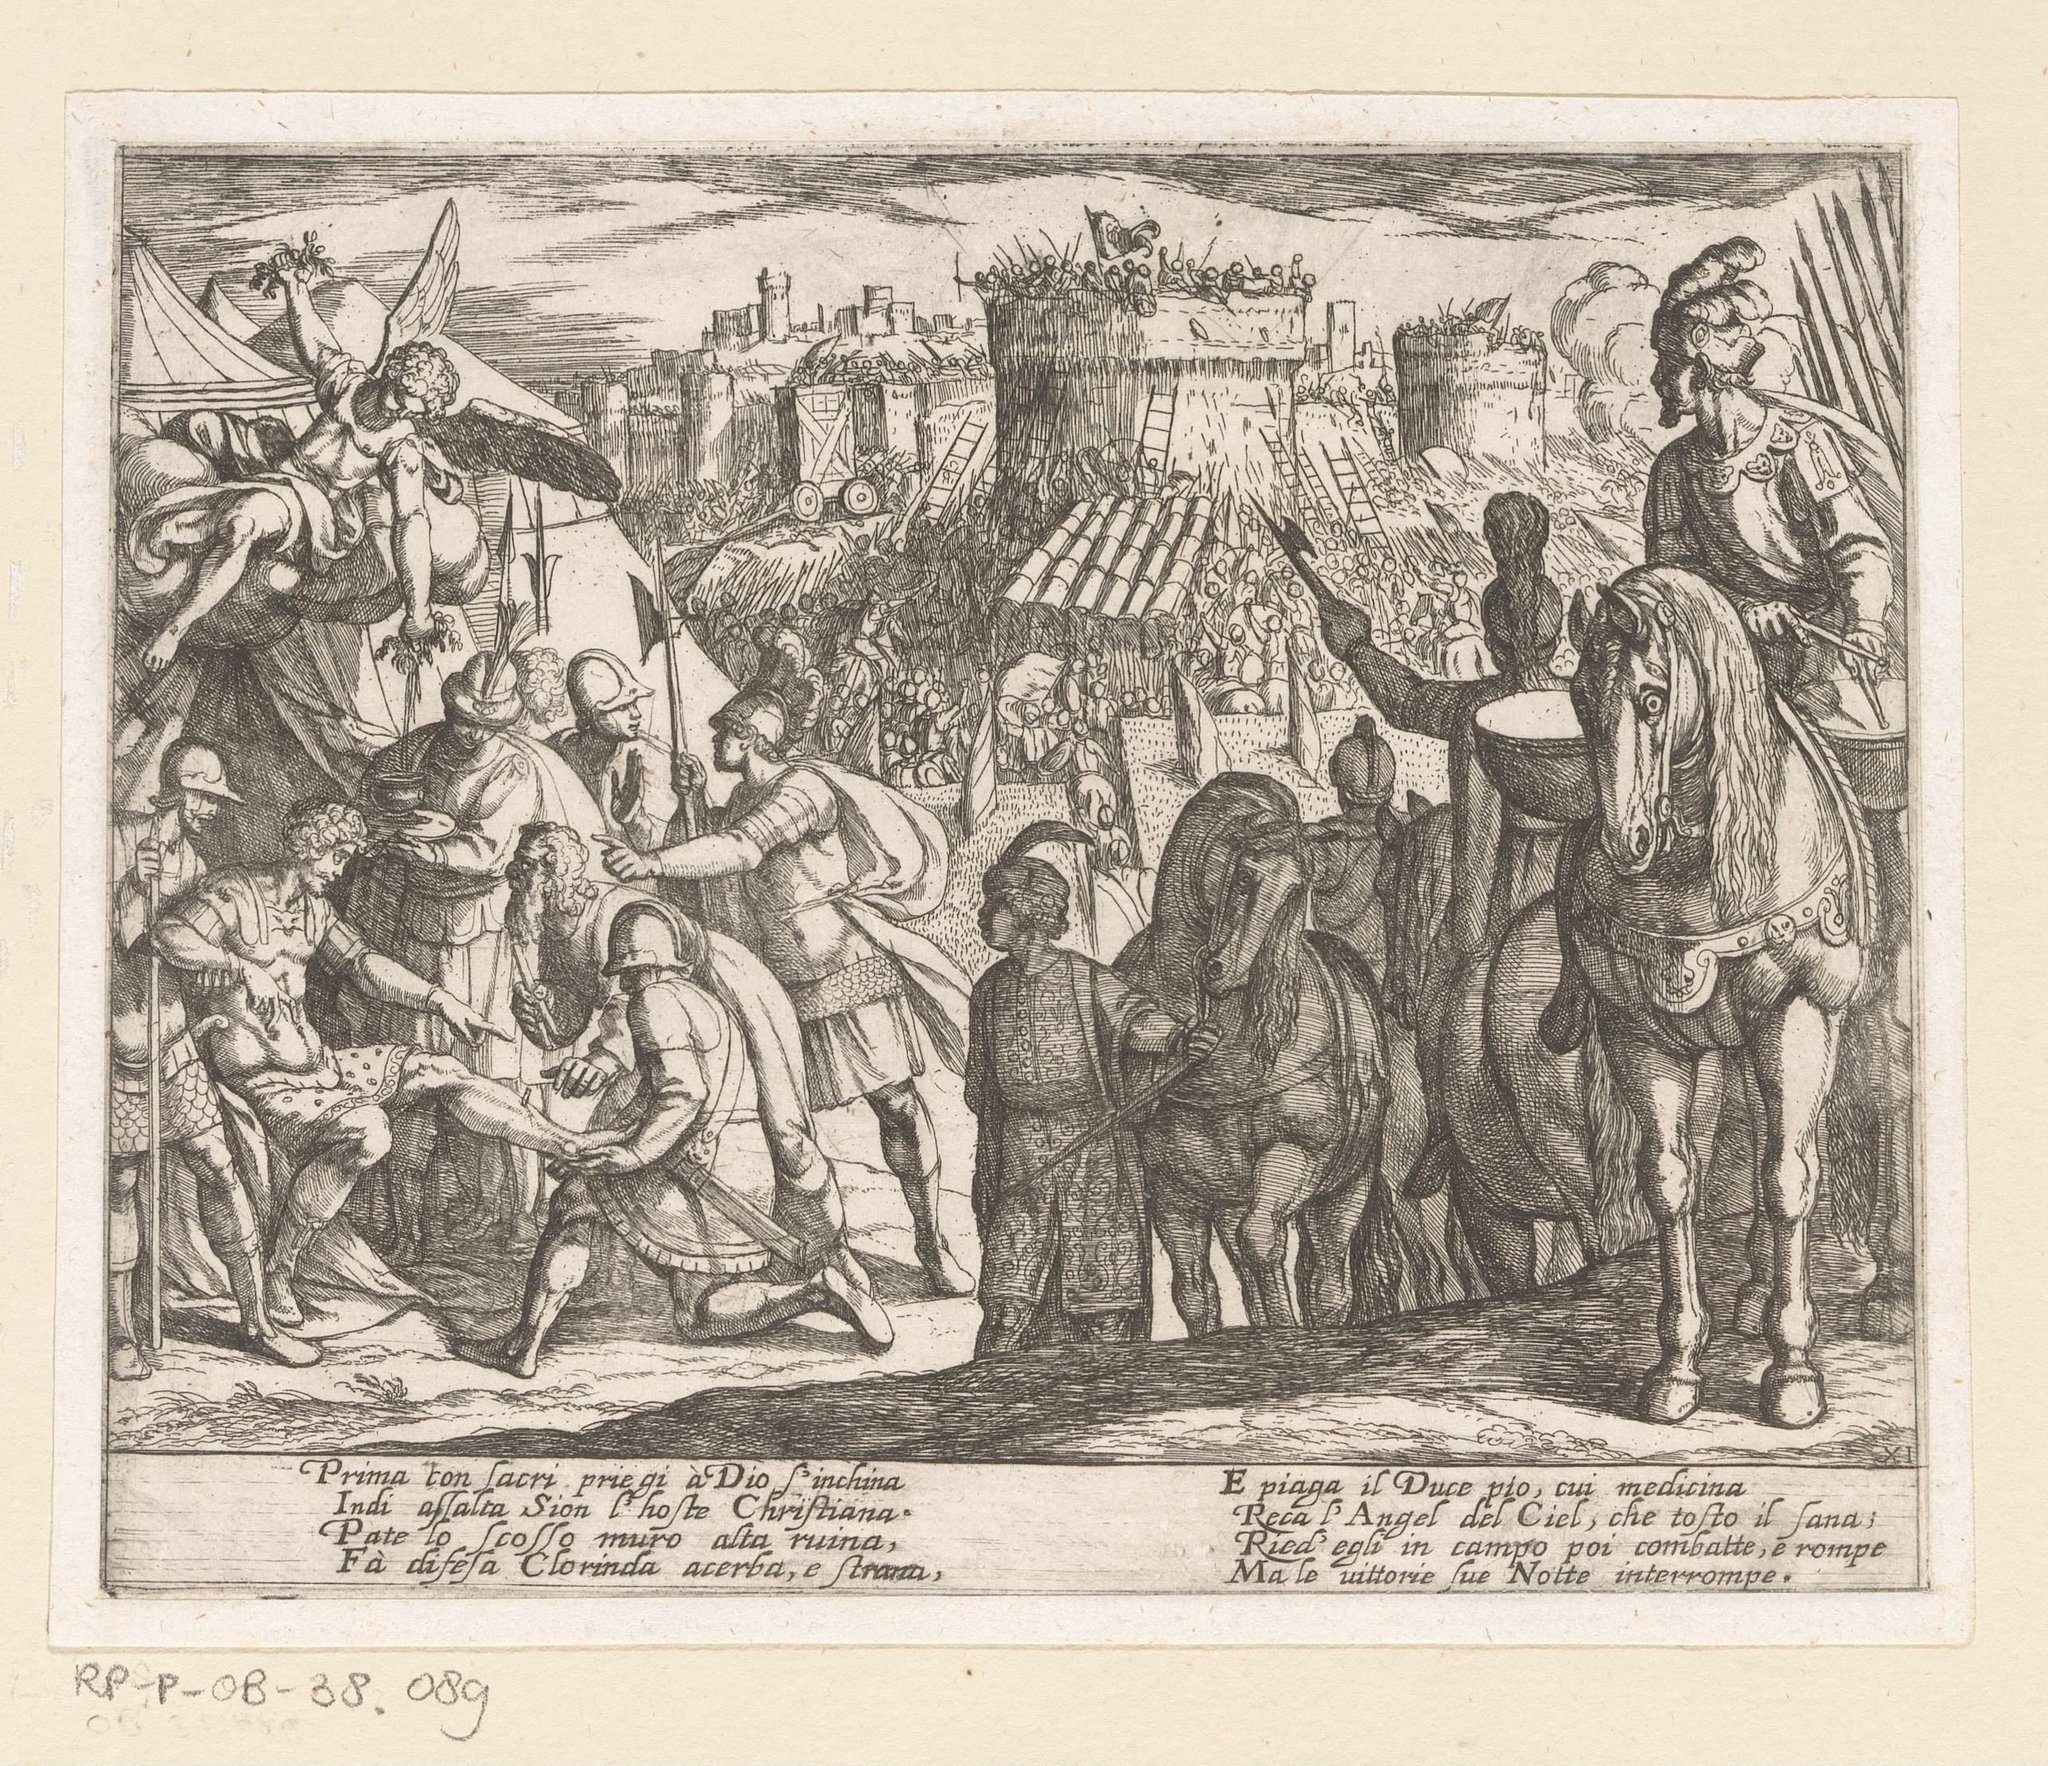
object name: print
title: Jeruzalem verlost (deel 2)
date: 1565-1630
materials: paper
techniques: etching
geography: italy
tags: battle, infections and wounds, militant proselytizing: religious war, crusade, etc., (scenes from) specific works of literature: tasso, gerusalemme liberata, knight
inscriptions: collector's mark: Lugt 240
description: Deze prent maakt deel uit van een reeks van twintig prenten (+ opdracht) met voorstellingen van scènes uit Tasso's 'Jeruzalem verlost', een episch gedicht geschreven door de Italiaanse dichter Torquato Tasso en voor het eerst gepubliceerd in 1581. Het verhaal vertelt grotendeels in fictie over de Eerste Kruistocht waarin de christenen, geleid door Godfried van Bouillon, de strijd aangaan met de moslims om het Beleg van Jeruzalem.